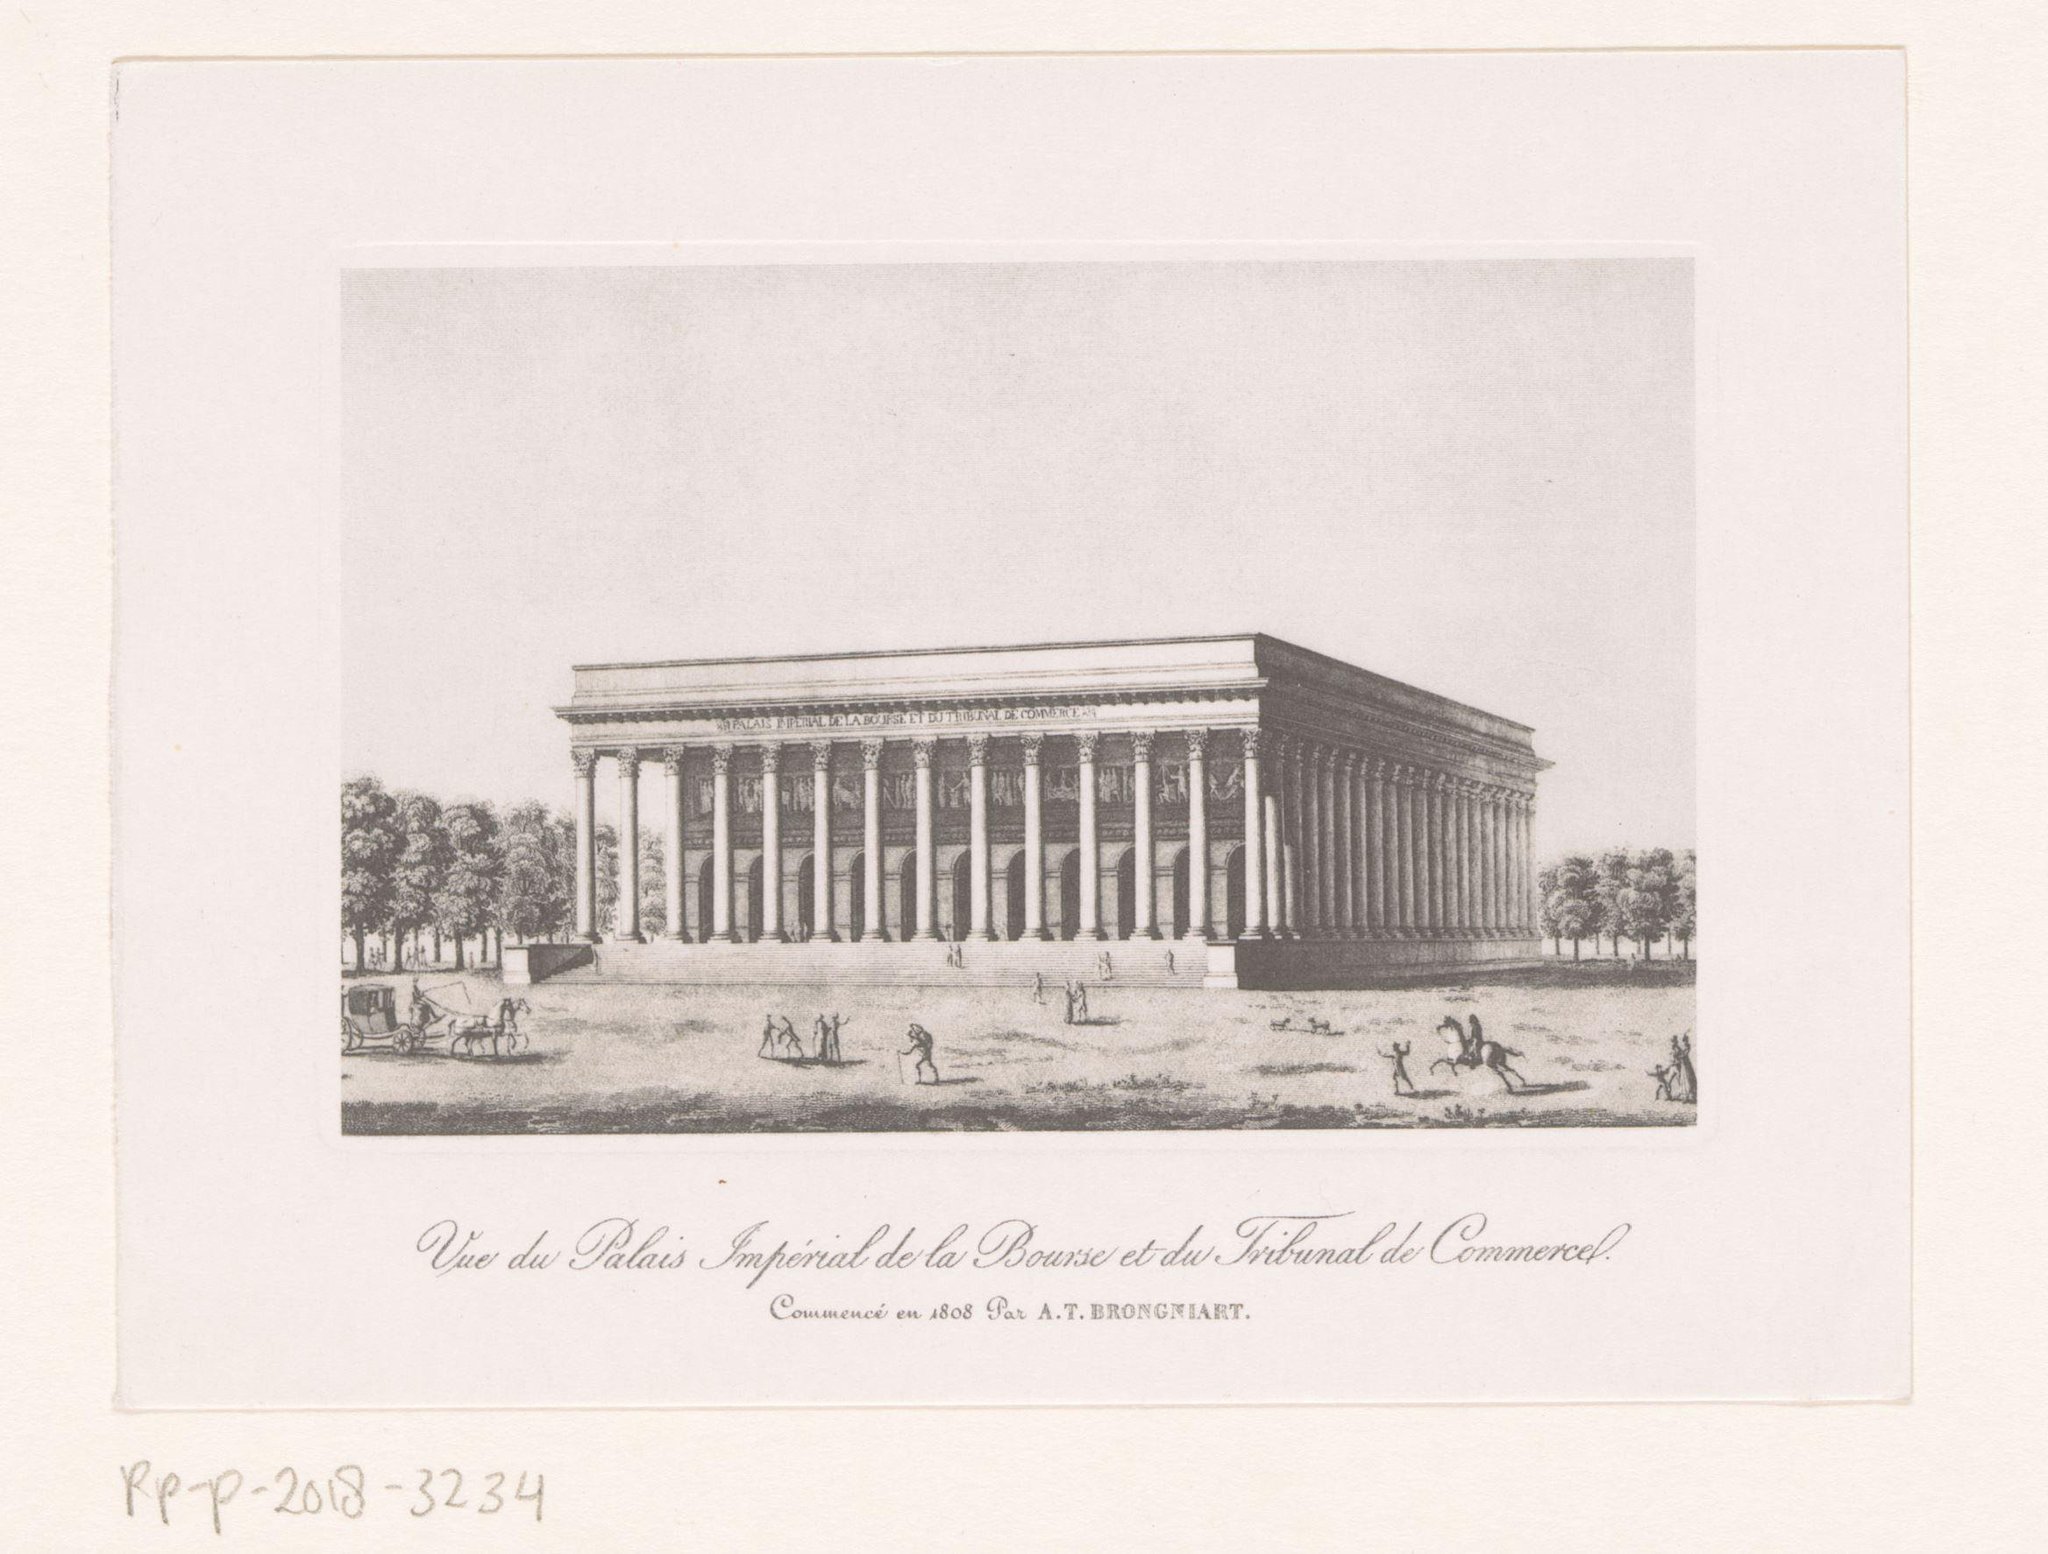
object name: print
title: Gezicht op het beursgebouw te Parijs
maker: Anonymous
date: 1826-1900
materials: paper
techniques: engraving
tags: stock exchange, stock-market, representation of real building (either existing or having existed), paris